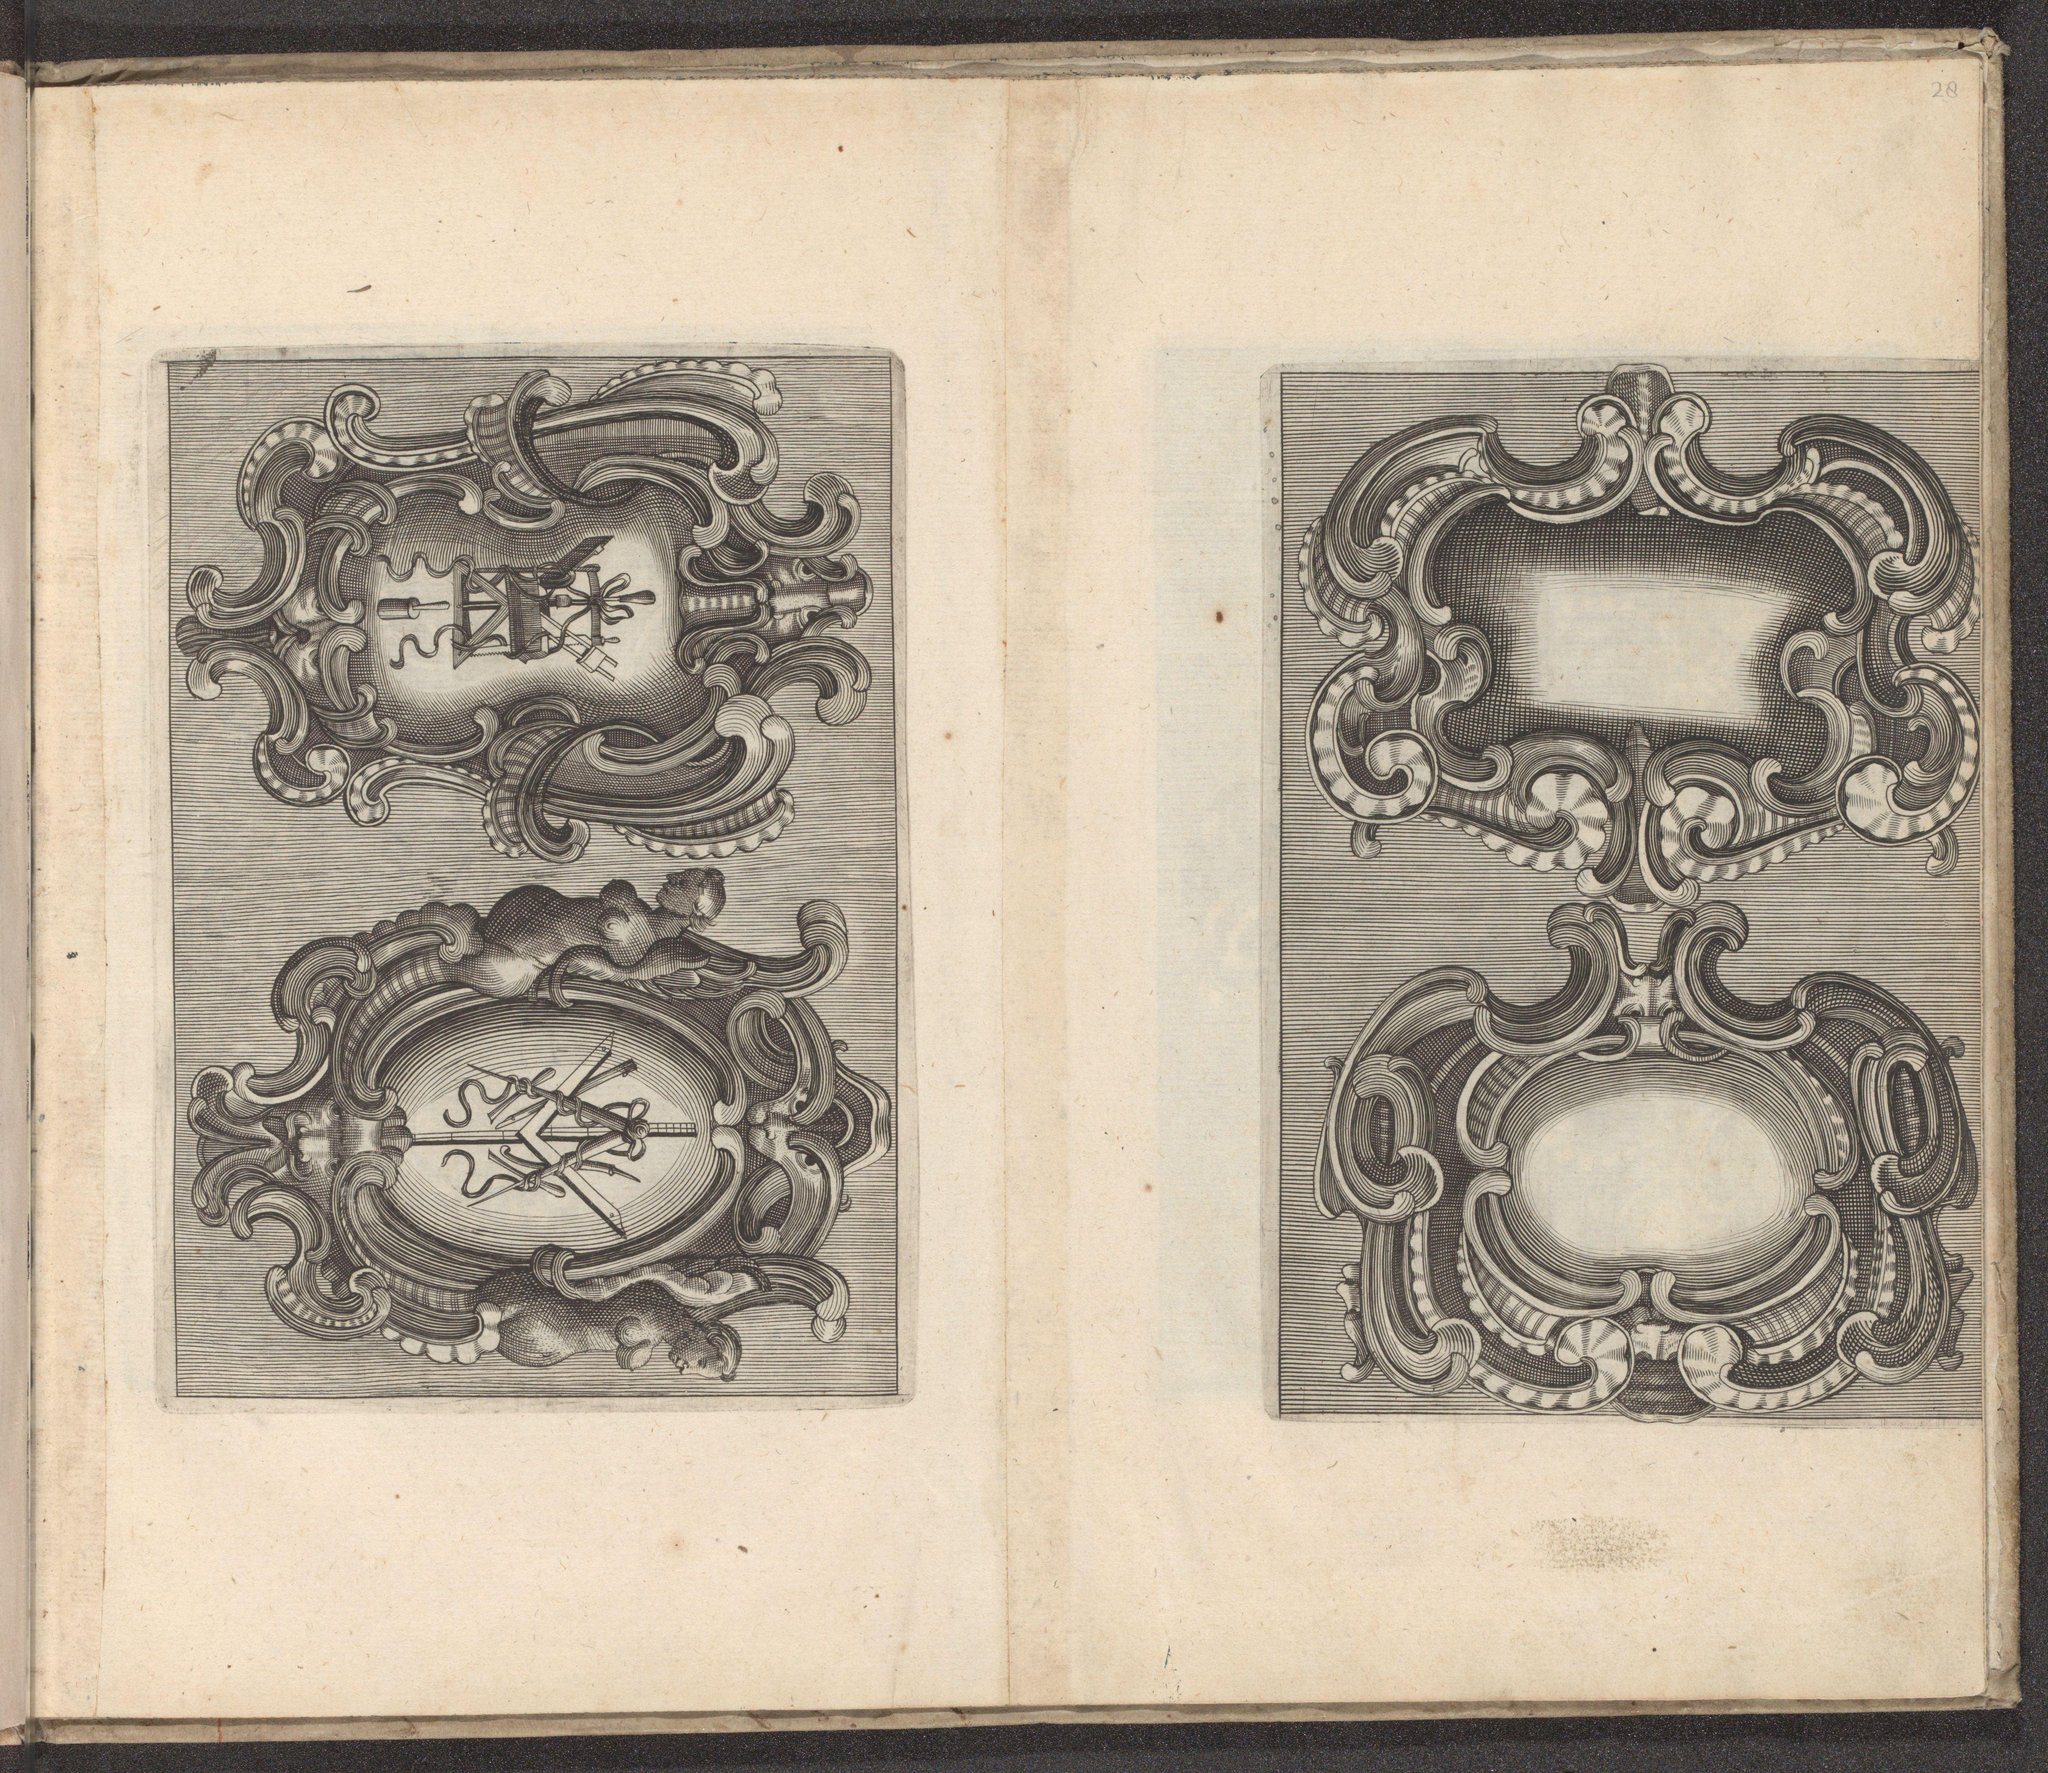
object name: album leaf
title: Verzierungen in Knorpelwerk für Schreiner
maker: Anonymous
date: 1600-1699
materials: paper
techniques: engraving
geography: germany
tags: joiner, cabinet maker, 'ébéniste', trophy, i.e.: decorative arrangement of symbolic or typical objects ~ ornament, auricular ornament, lobe style ~ ornament, ornament ~ cartouche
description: Twee voorstellingen op een tweedelig albumblad. Op elke voorstelling twee cartouches met een omlijsting in kwabstijl. In de twee cartouches links trofeeën van meubelmakersgereedschap. De prent maakt deel uit van een album.